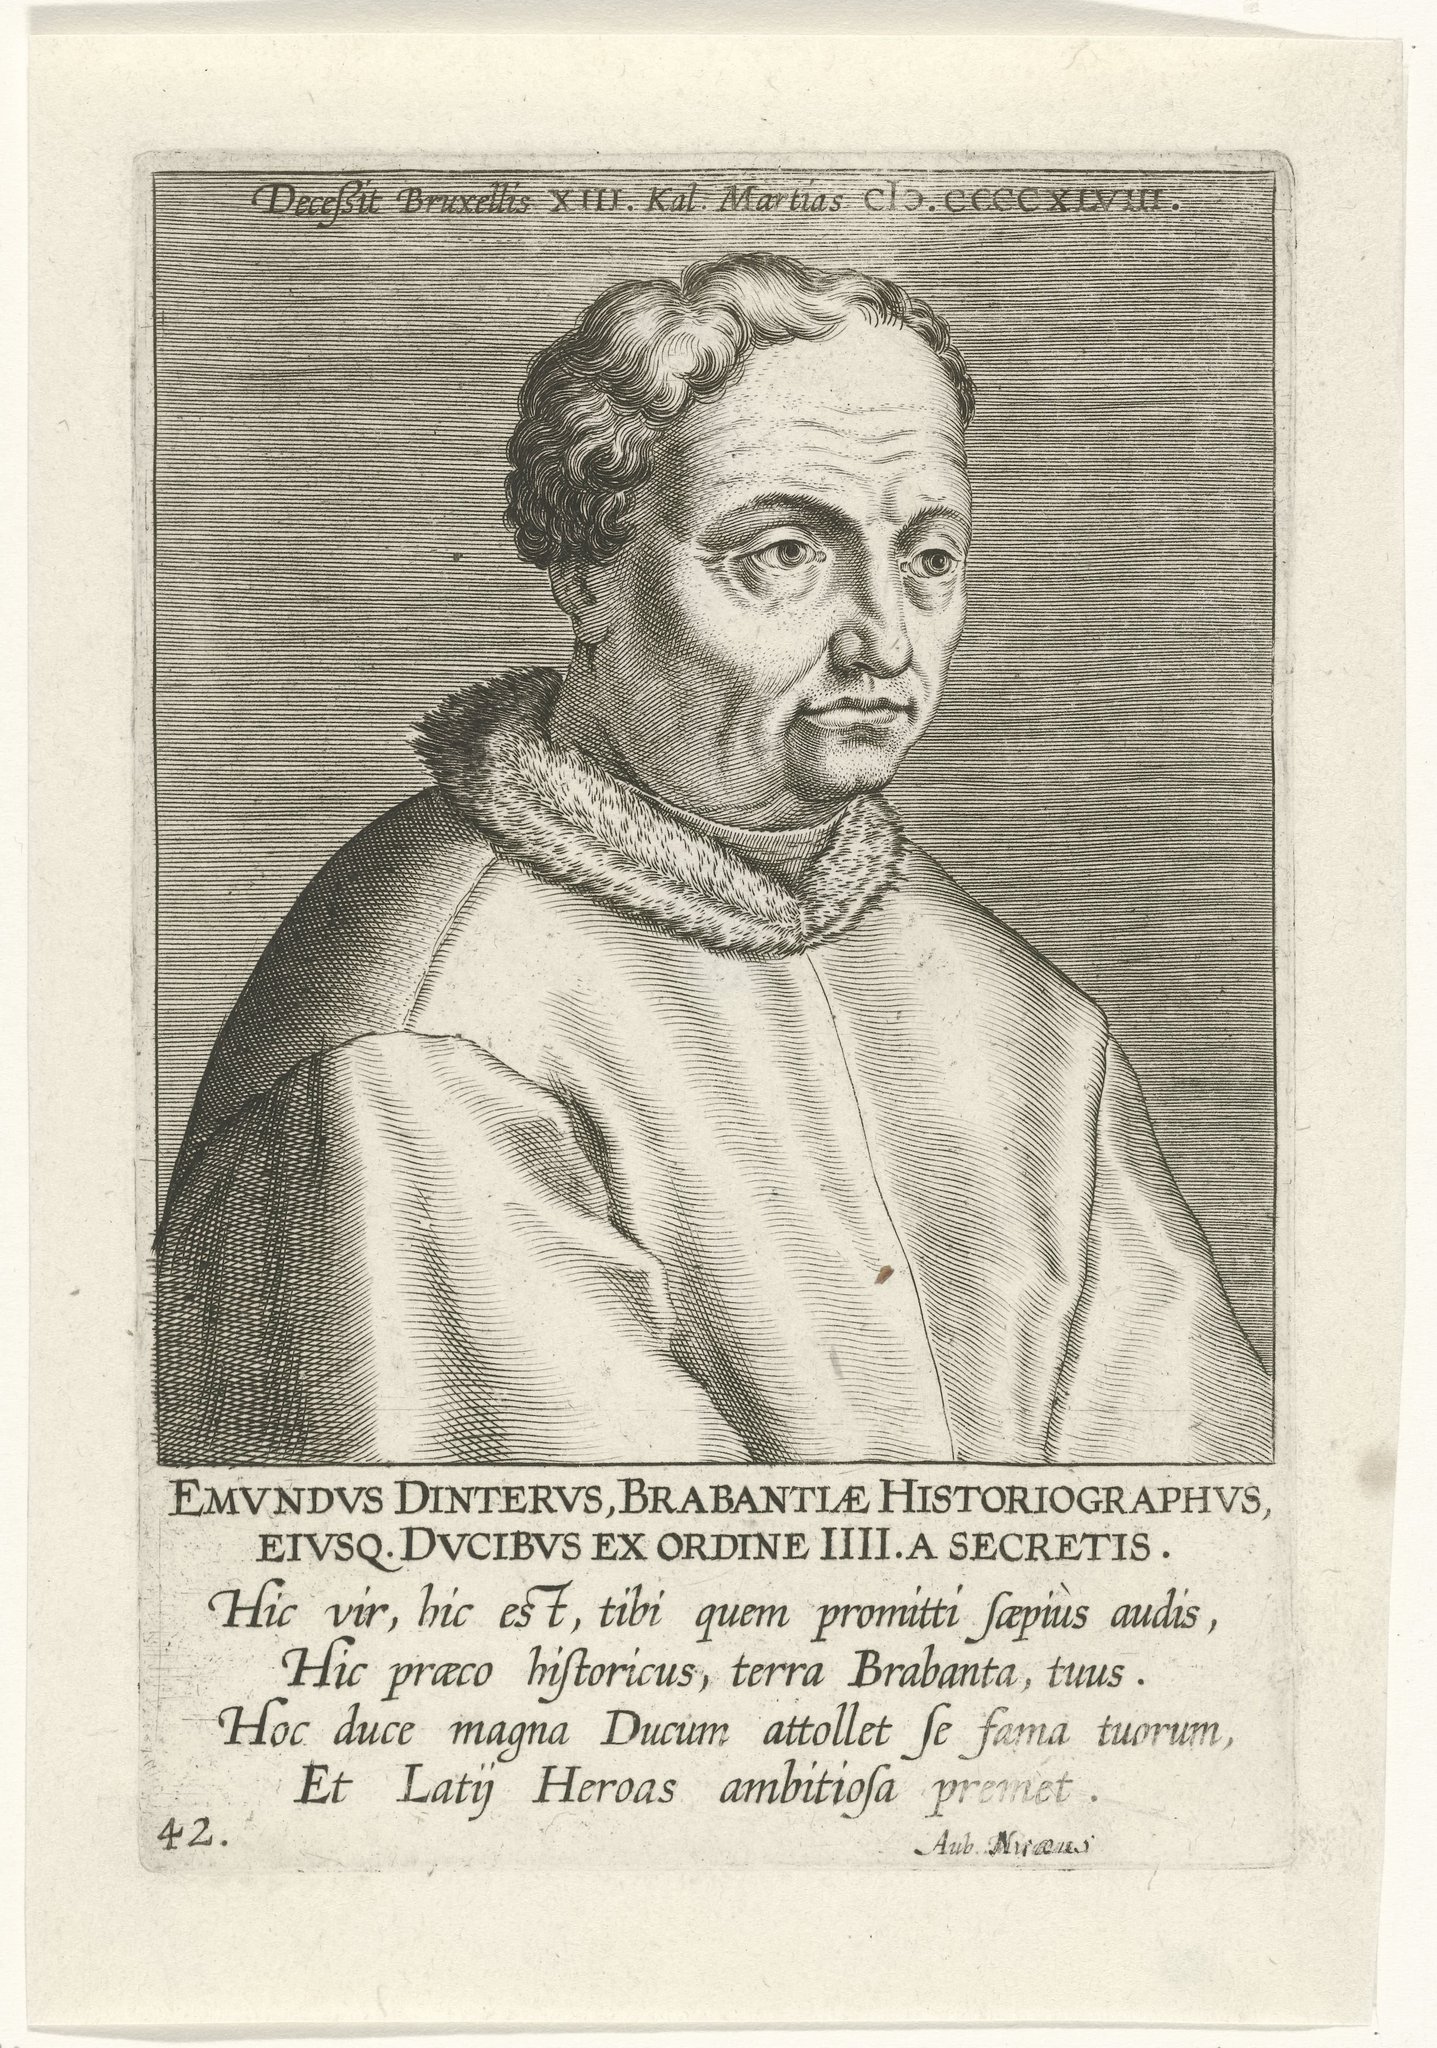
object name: print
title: Emvndvs Dintervs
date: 1604-1608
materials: paper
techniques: engraving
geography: antwerp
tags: brussels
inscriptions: collector's mark: Lugt 2228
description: Portret van Edmund van Dinter. Diplomaat en geschiedschrijver. Buste naar rechts. De prent heeft een Latijns boven- en onderschrift en maakt deel uit van een serie van beroemde Nederlandse en Vlaamse geleerden.